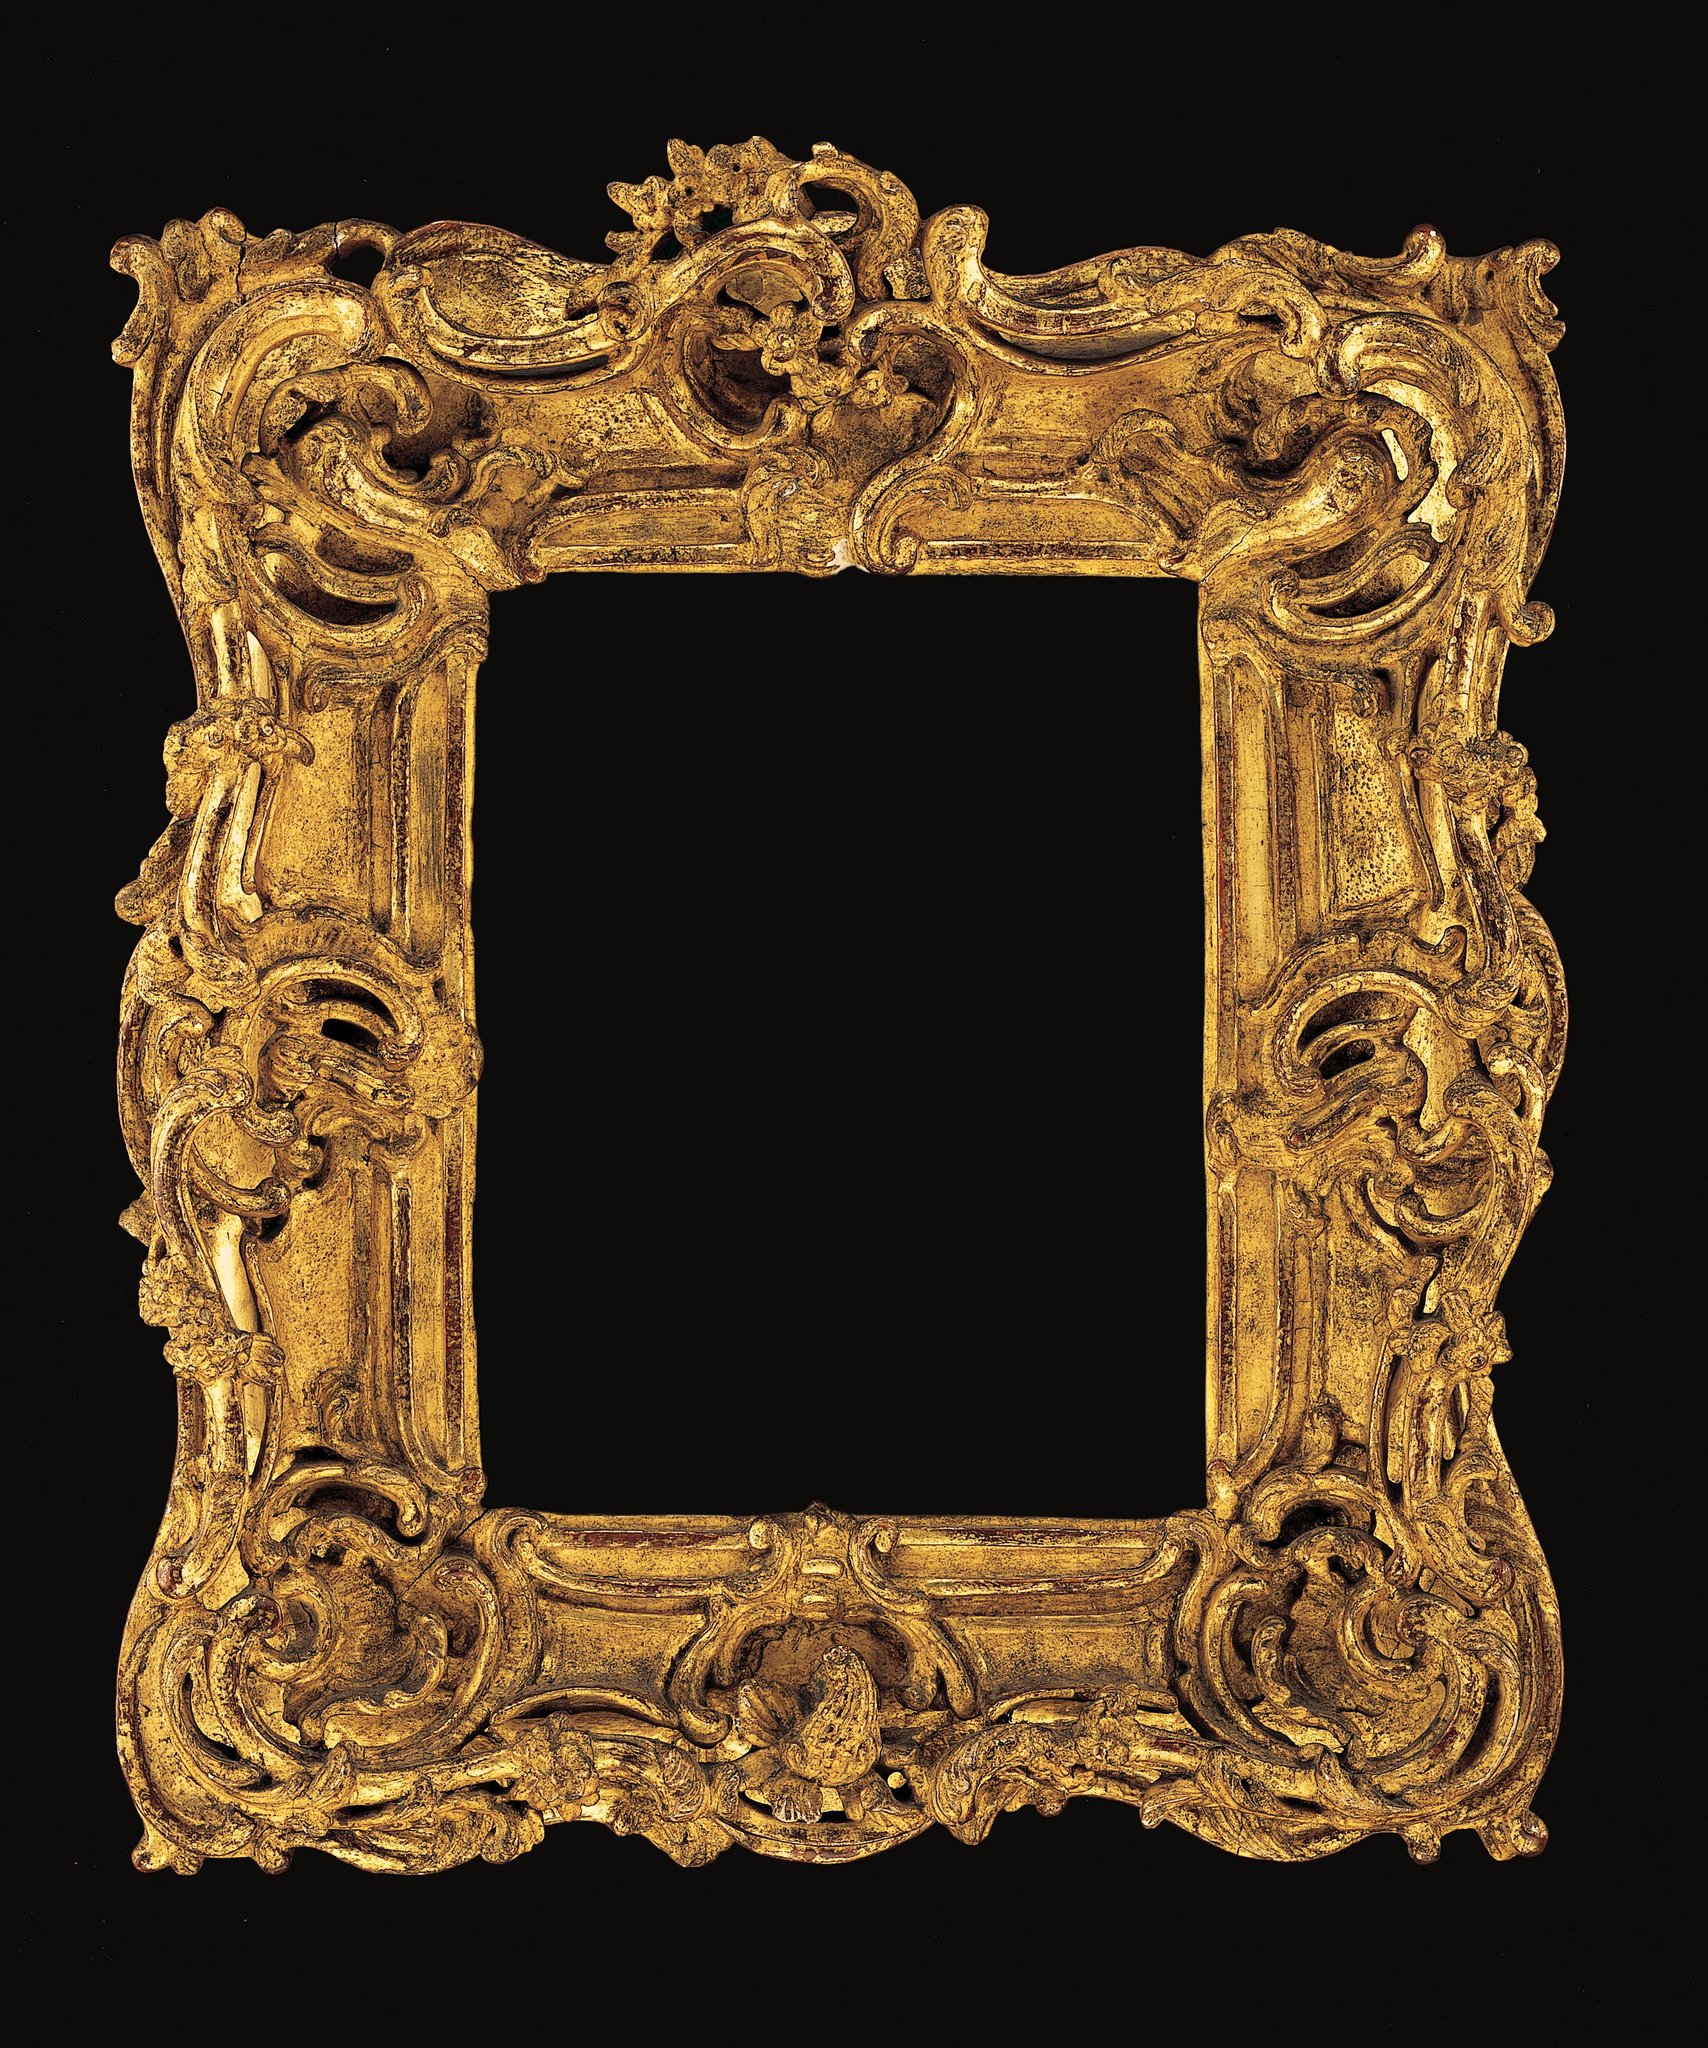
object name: frame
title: Swept frame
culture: french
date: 1750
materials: wood